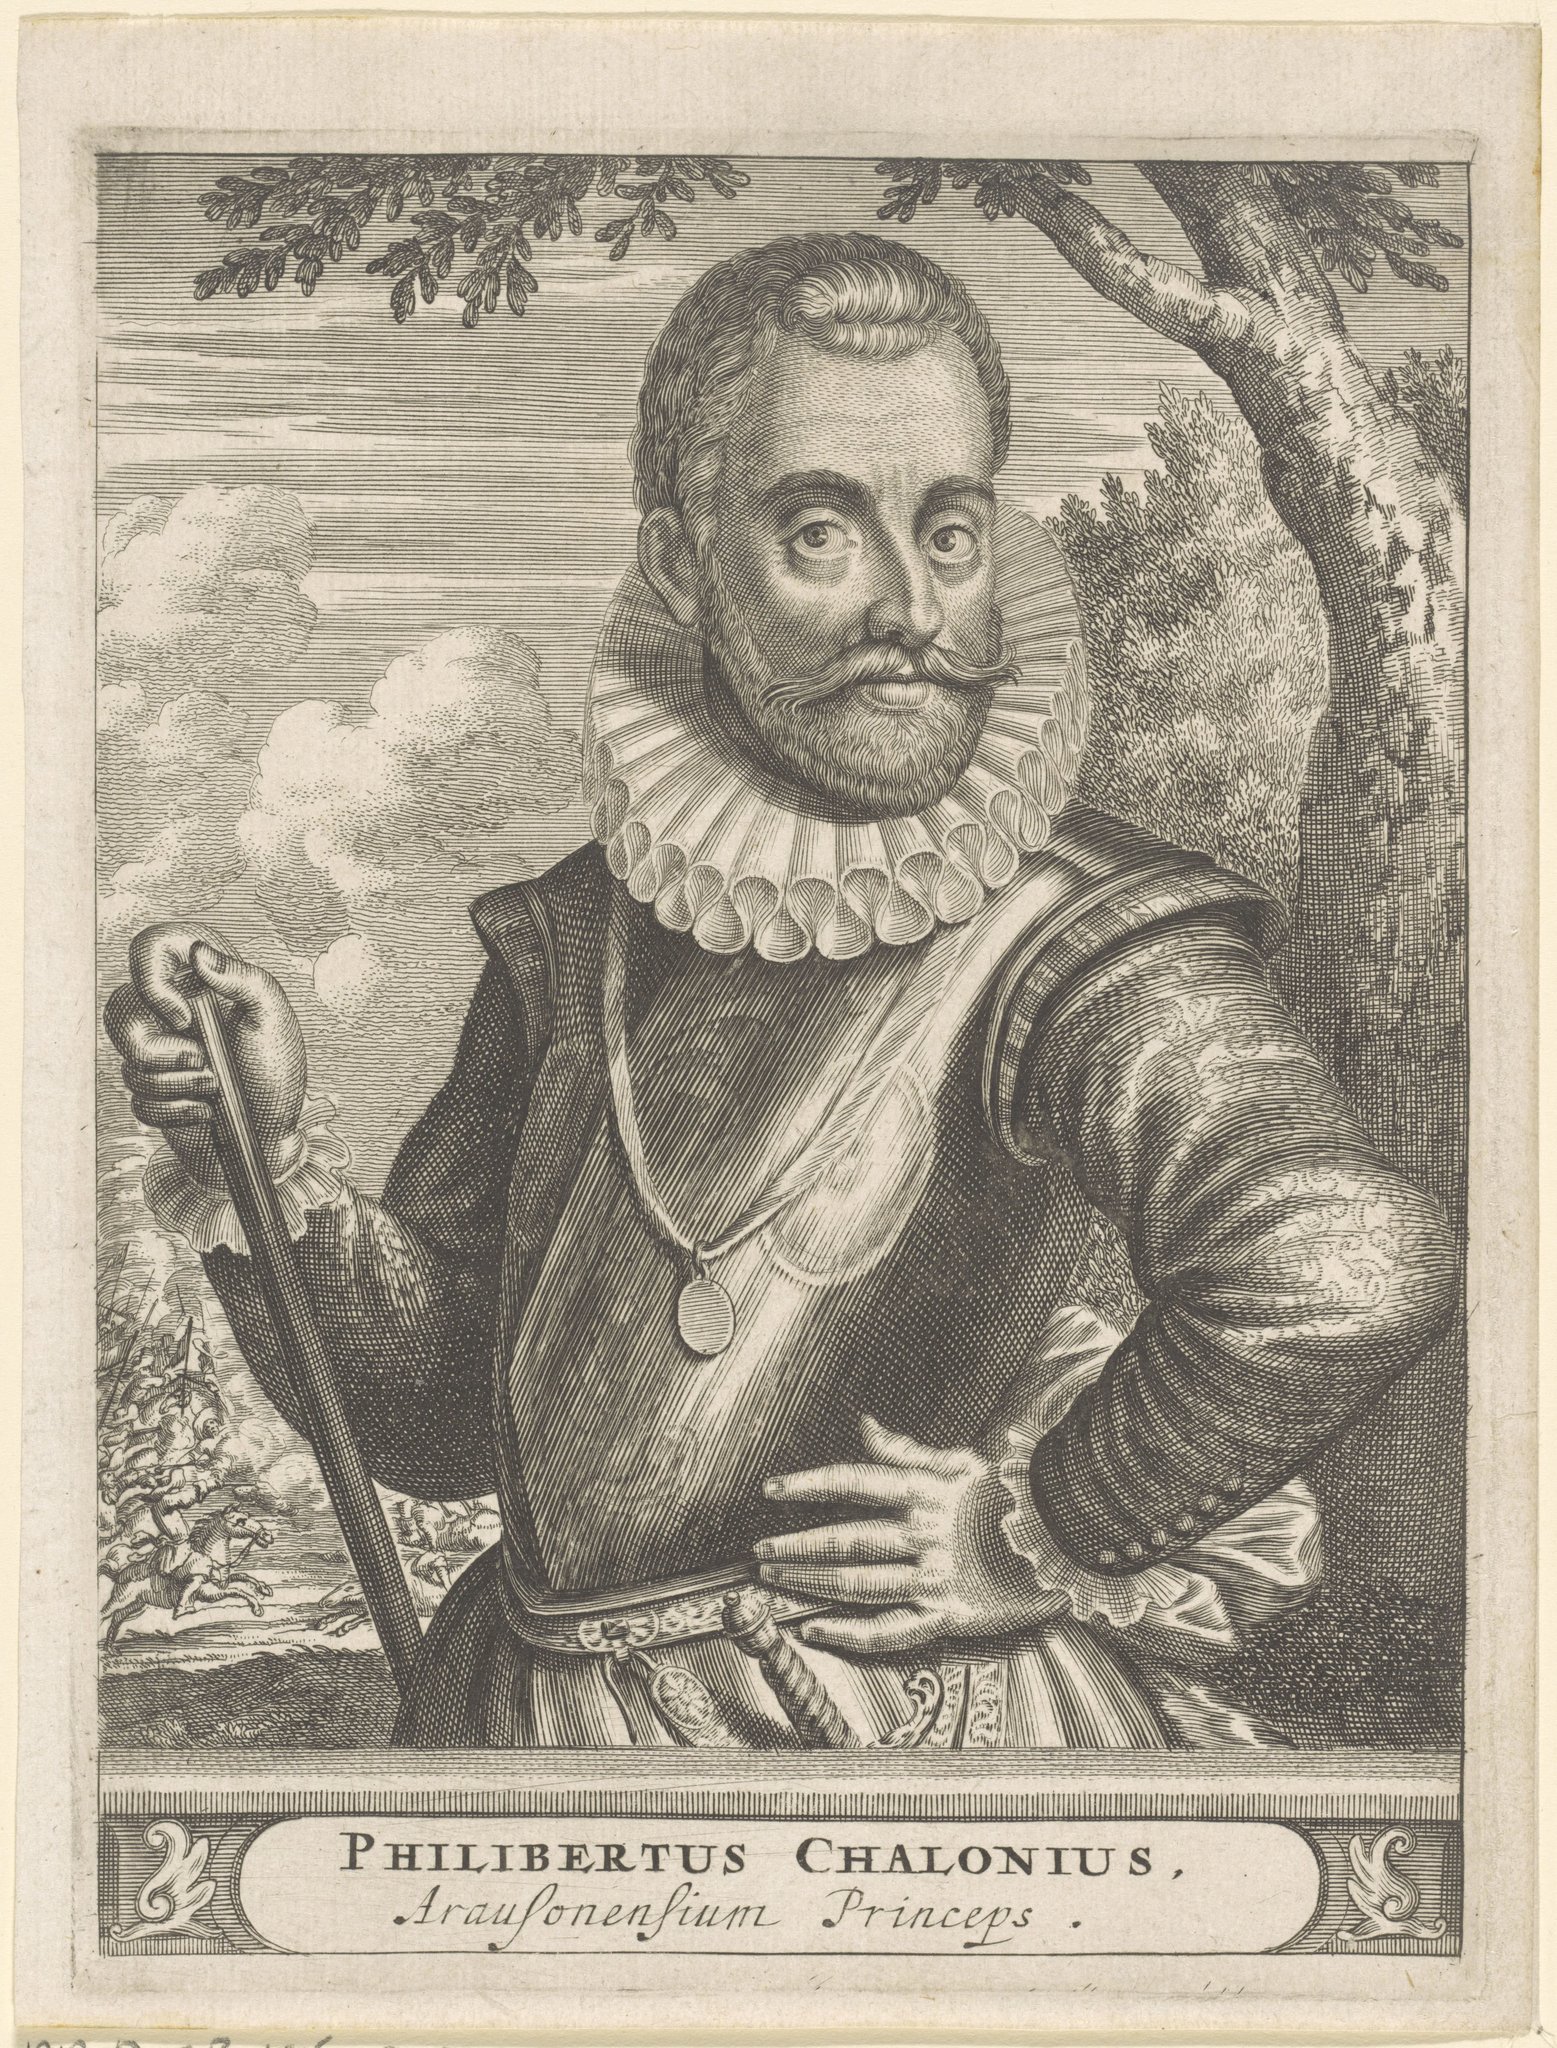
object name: print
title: Portret van Philibert van Châlon, prins van Oranje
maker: Anonymous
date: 1600-1699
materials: paper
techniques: engraving, etching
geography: low countries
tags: lons-le-saunier, prins, philibert van châlon (prins van oranje)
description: De hier vermelde titel verwijst naar de hoogst verkregen titel van de geportretteerde, niet per se naar de titel die de geportretteerde op deze voorstelling draagt.